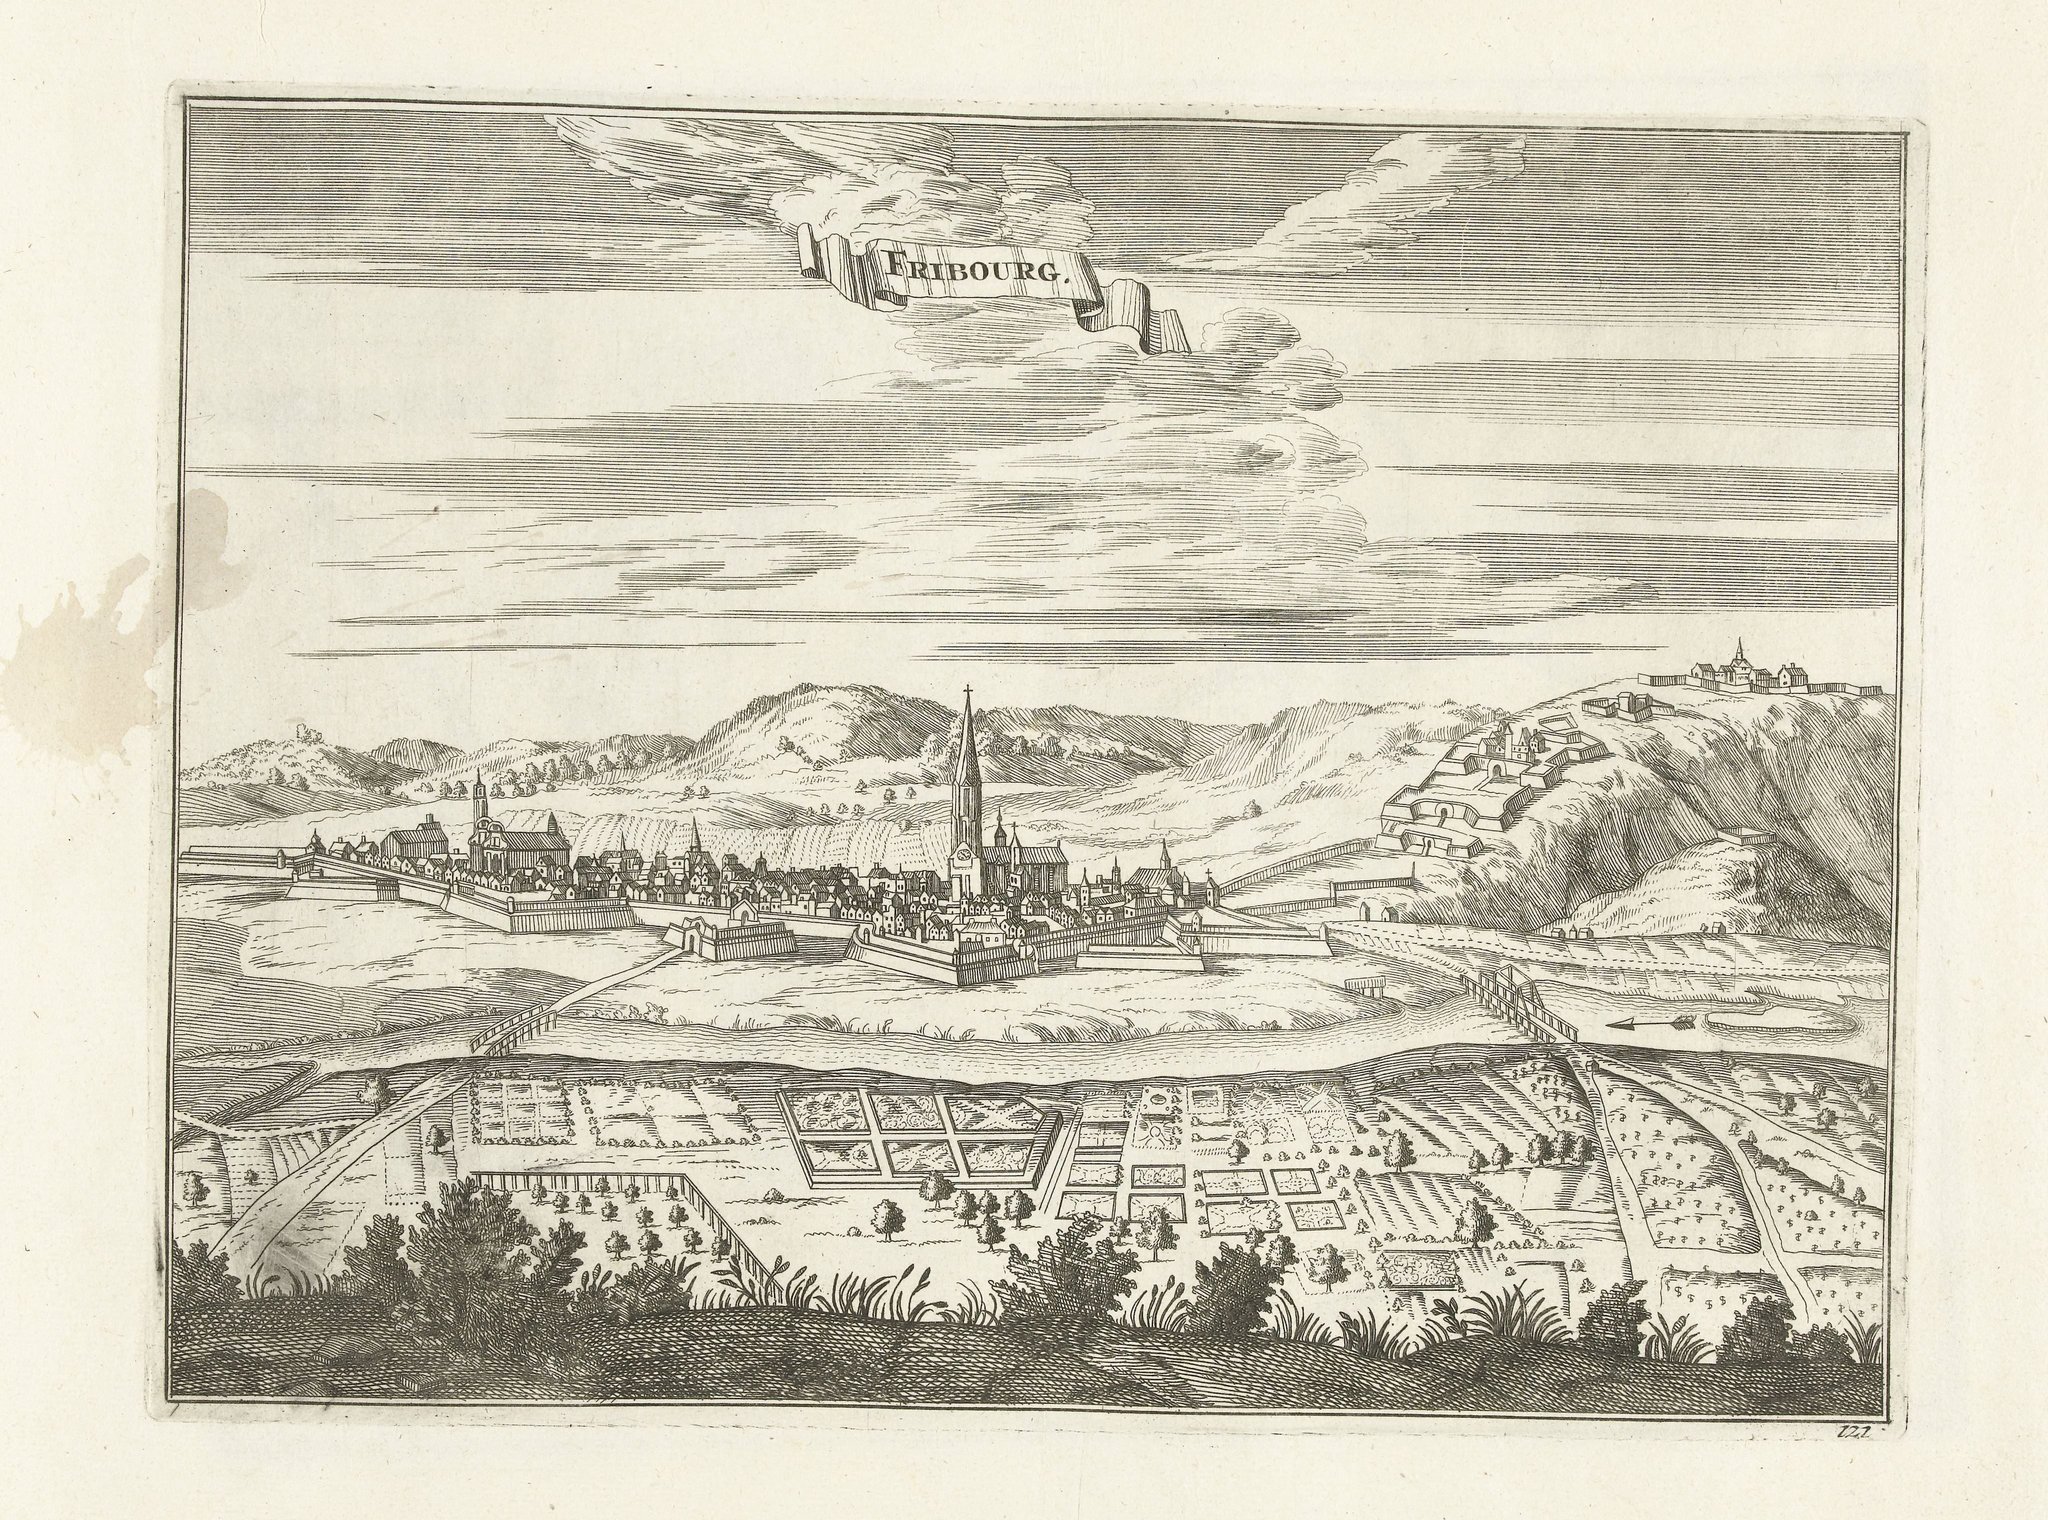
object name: print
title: Les Forces de l'Europe, Asie, Afrique et Amerique, ou description des principales villes avec leurs fortifications. Dessignées par les meilleurs ingenieurs, particulierement celles qui sont sous la domination de la France (...) et ornées de plusieurs superbes edifices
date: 1702-1703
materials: paper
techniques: etching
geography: amsterdam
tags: fribourg, spaanse successieoorlog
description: Gezicht op de stad Fribourg. Plaat nr. 121 in het prentwerk bestaande in totaal uit 276 genummerde platen van vermaarde sterke steden en vestingen in het kader van de Spaanse Successieoorlog. Voor het merendeel zijn deze platen gekopieerd naar de anonieme Franse platen: in Les forces de l'Europe en in: Le theatre de la guerre, dans les Pays-Bas, beide oorspronkelijk uitgegeven door Nicolas de Fer te Parijs (1693-1697) in het kader van de Negenjarige Oorlog.